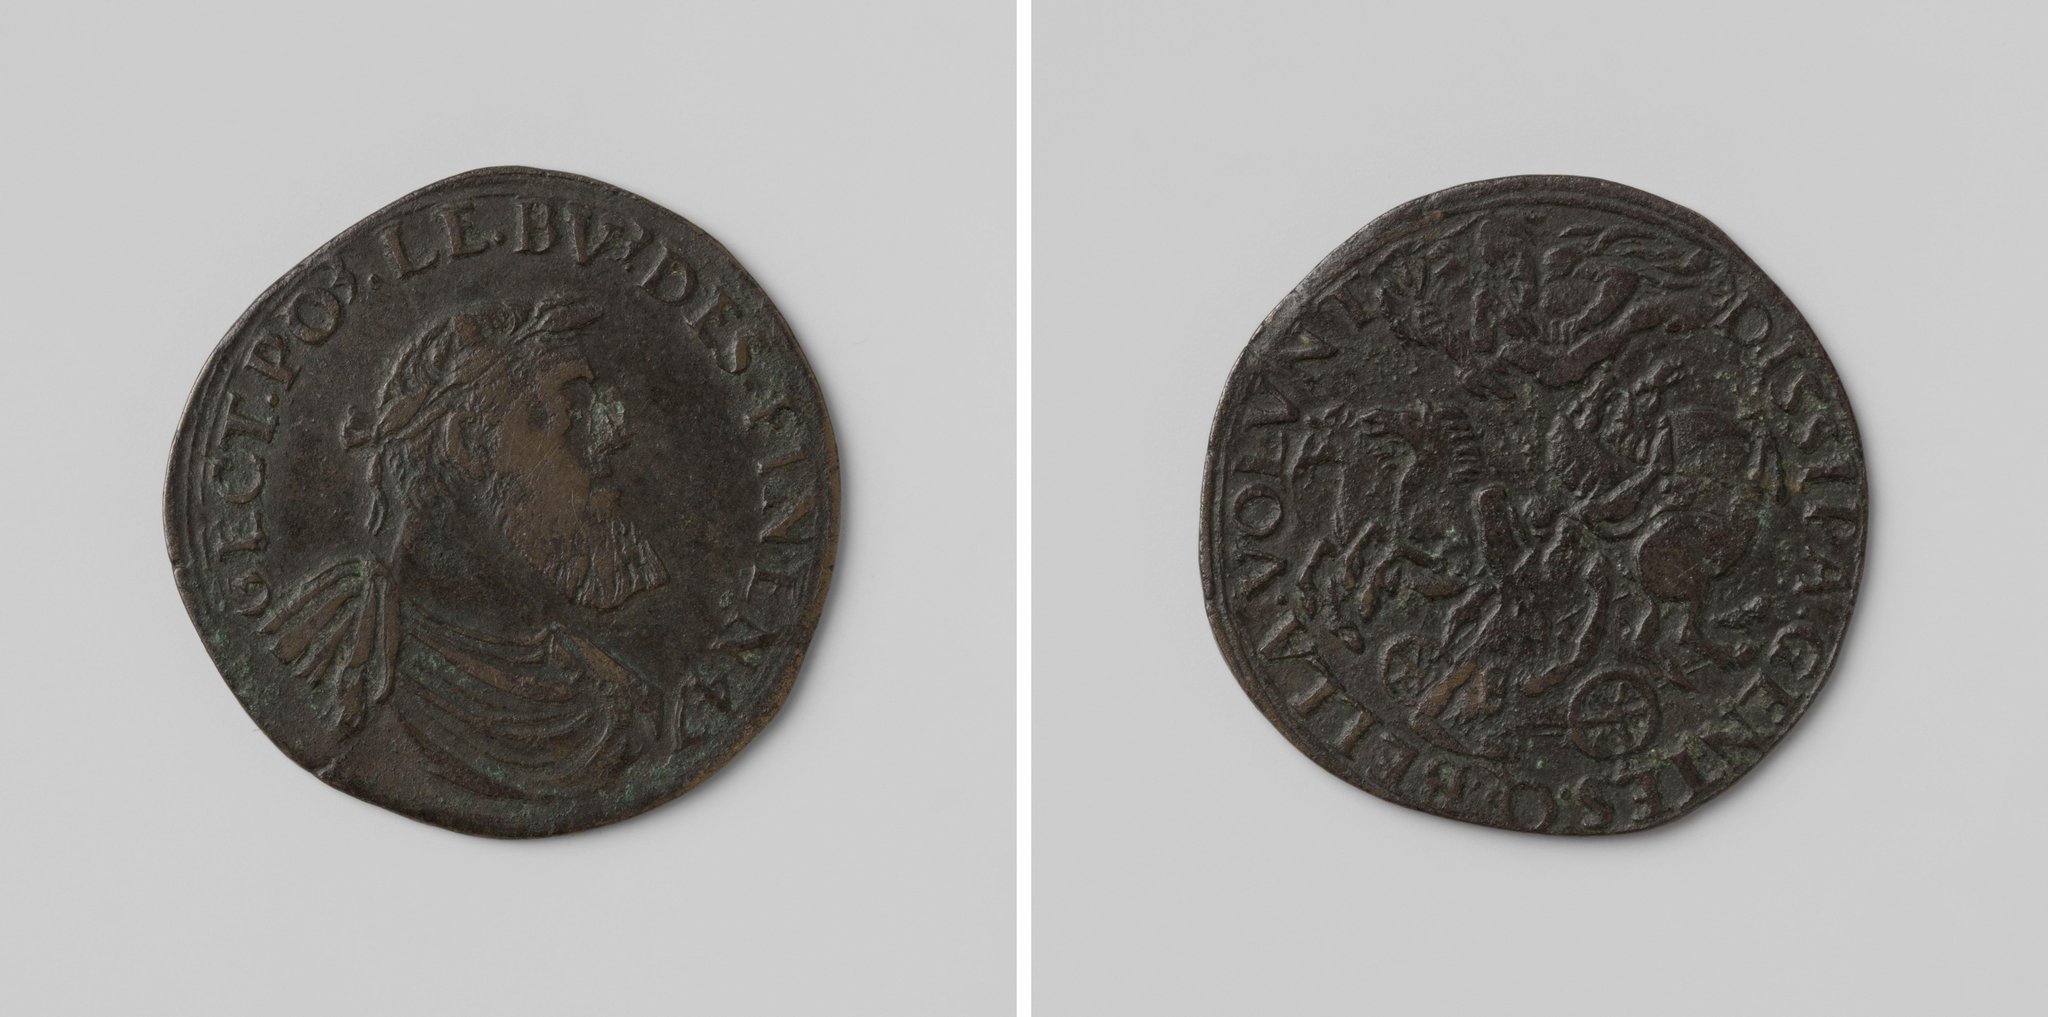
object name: jeton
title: Onenigheid met paus Paulus III en Hendrik II, koning van Frankrijk, rekenpenning van de raad van Financiën, ter ere van Karel V, Duits keizer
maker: Anonymous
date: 1547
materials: copper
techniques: striking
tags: priest, paulus iii, ghent, charles v (holy roman emperor and king of spain), paris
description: Koperen penning. Voorzijde: borststuk man met lauwerkrans binnen omschrift. Keerzijde: Jupitter werpt met bliksem Phaeton uit zonnewagen binnen omschrift.